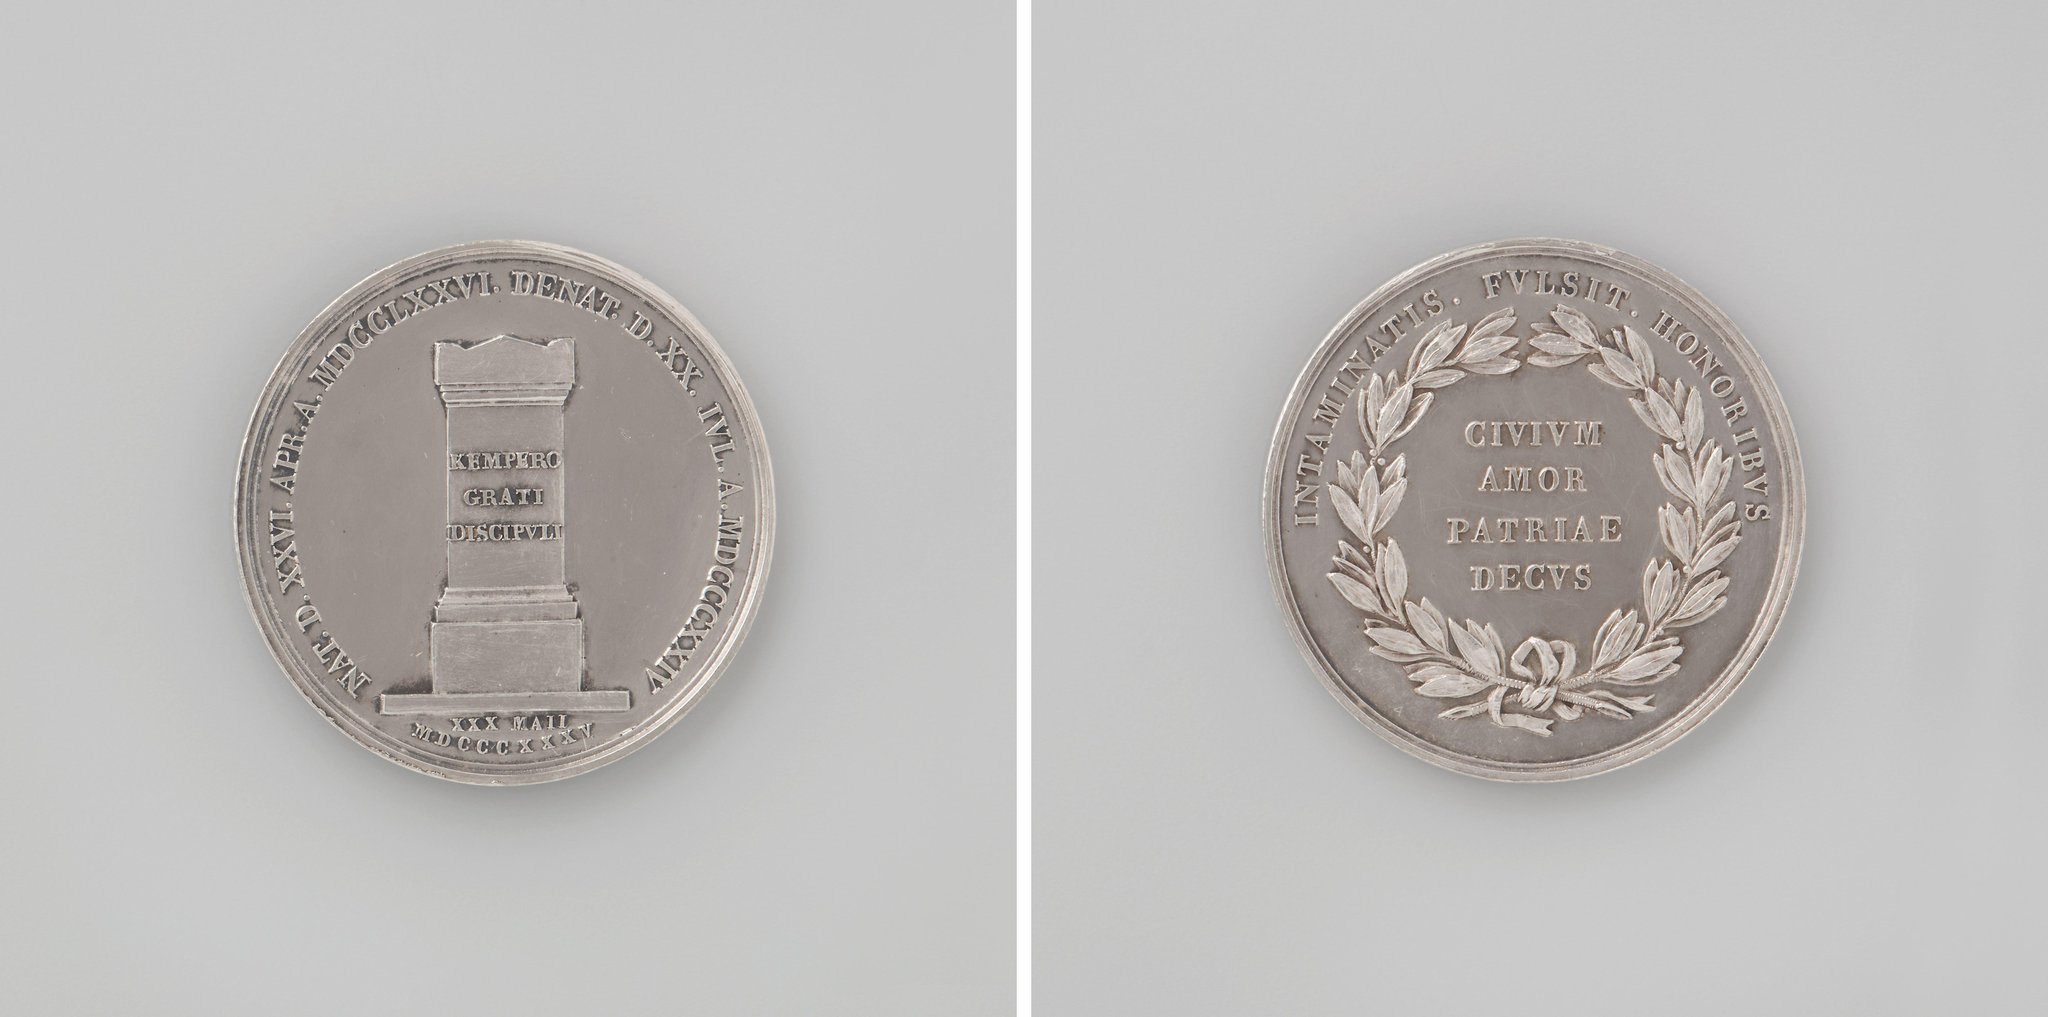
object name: history medal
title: Oprichting van een monument voor Joan Melchior Kemper in de St. Pieterskerk te Leiden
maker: johan philip menger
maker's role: medailleur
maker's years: 1818-1895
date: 1835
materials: silver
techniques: striking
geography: utrecht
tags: amsterdam, leiden, jonkheer joan melchior kemper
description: Zilveren penning. Voorzijde: monument met opschrift binnen omschrift; afsnede: datering. Keerzijde: opschrift binnen lauwerkrans en omschrift.